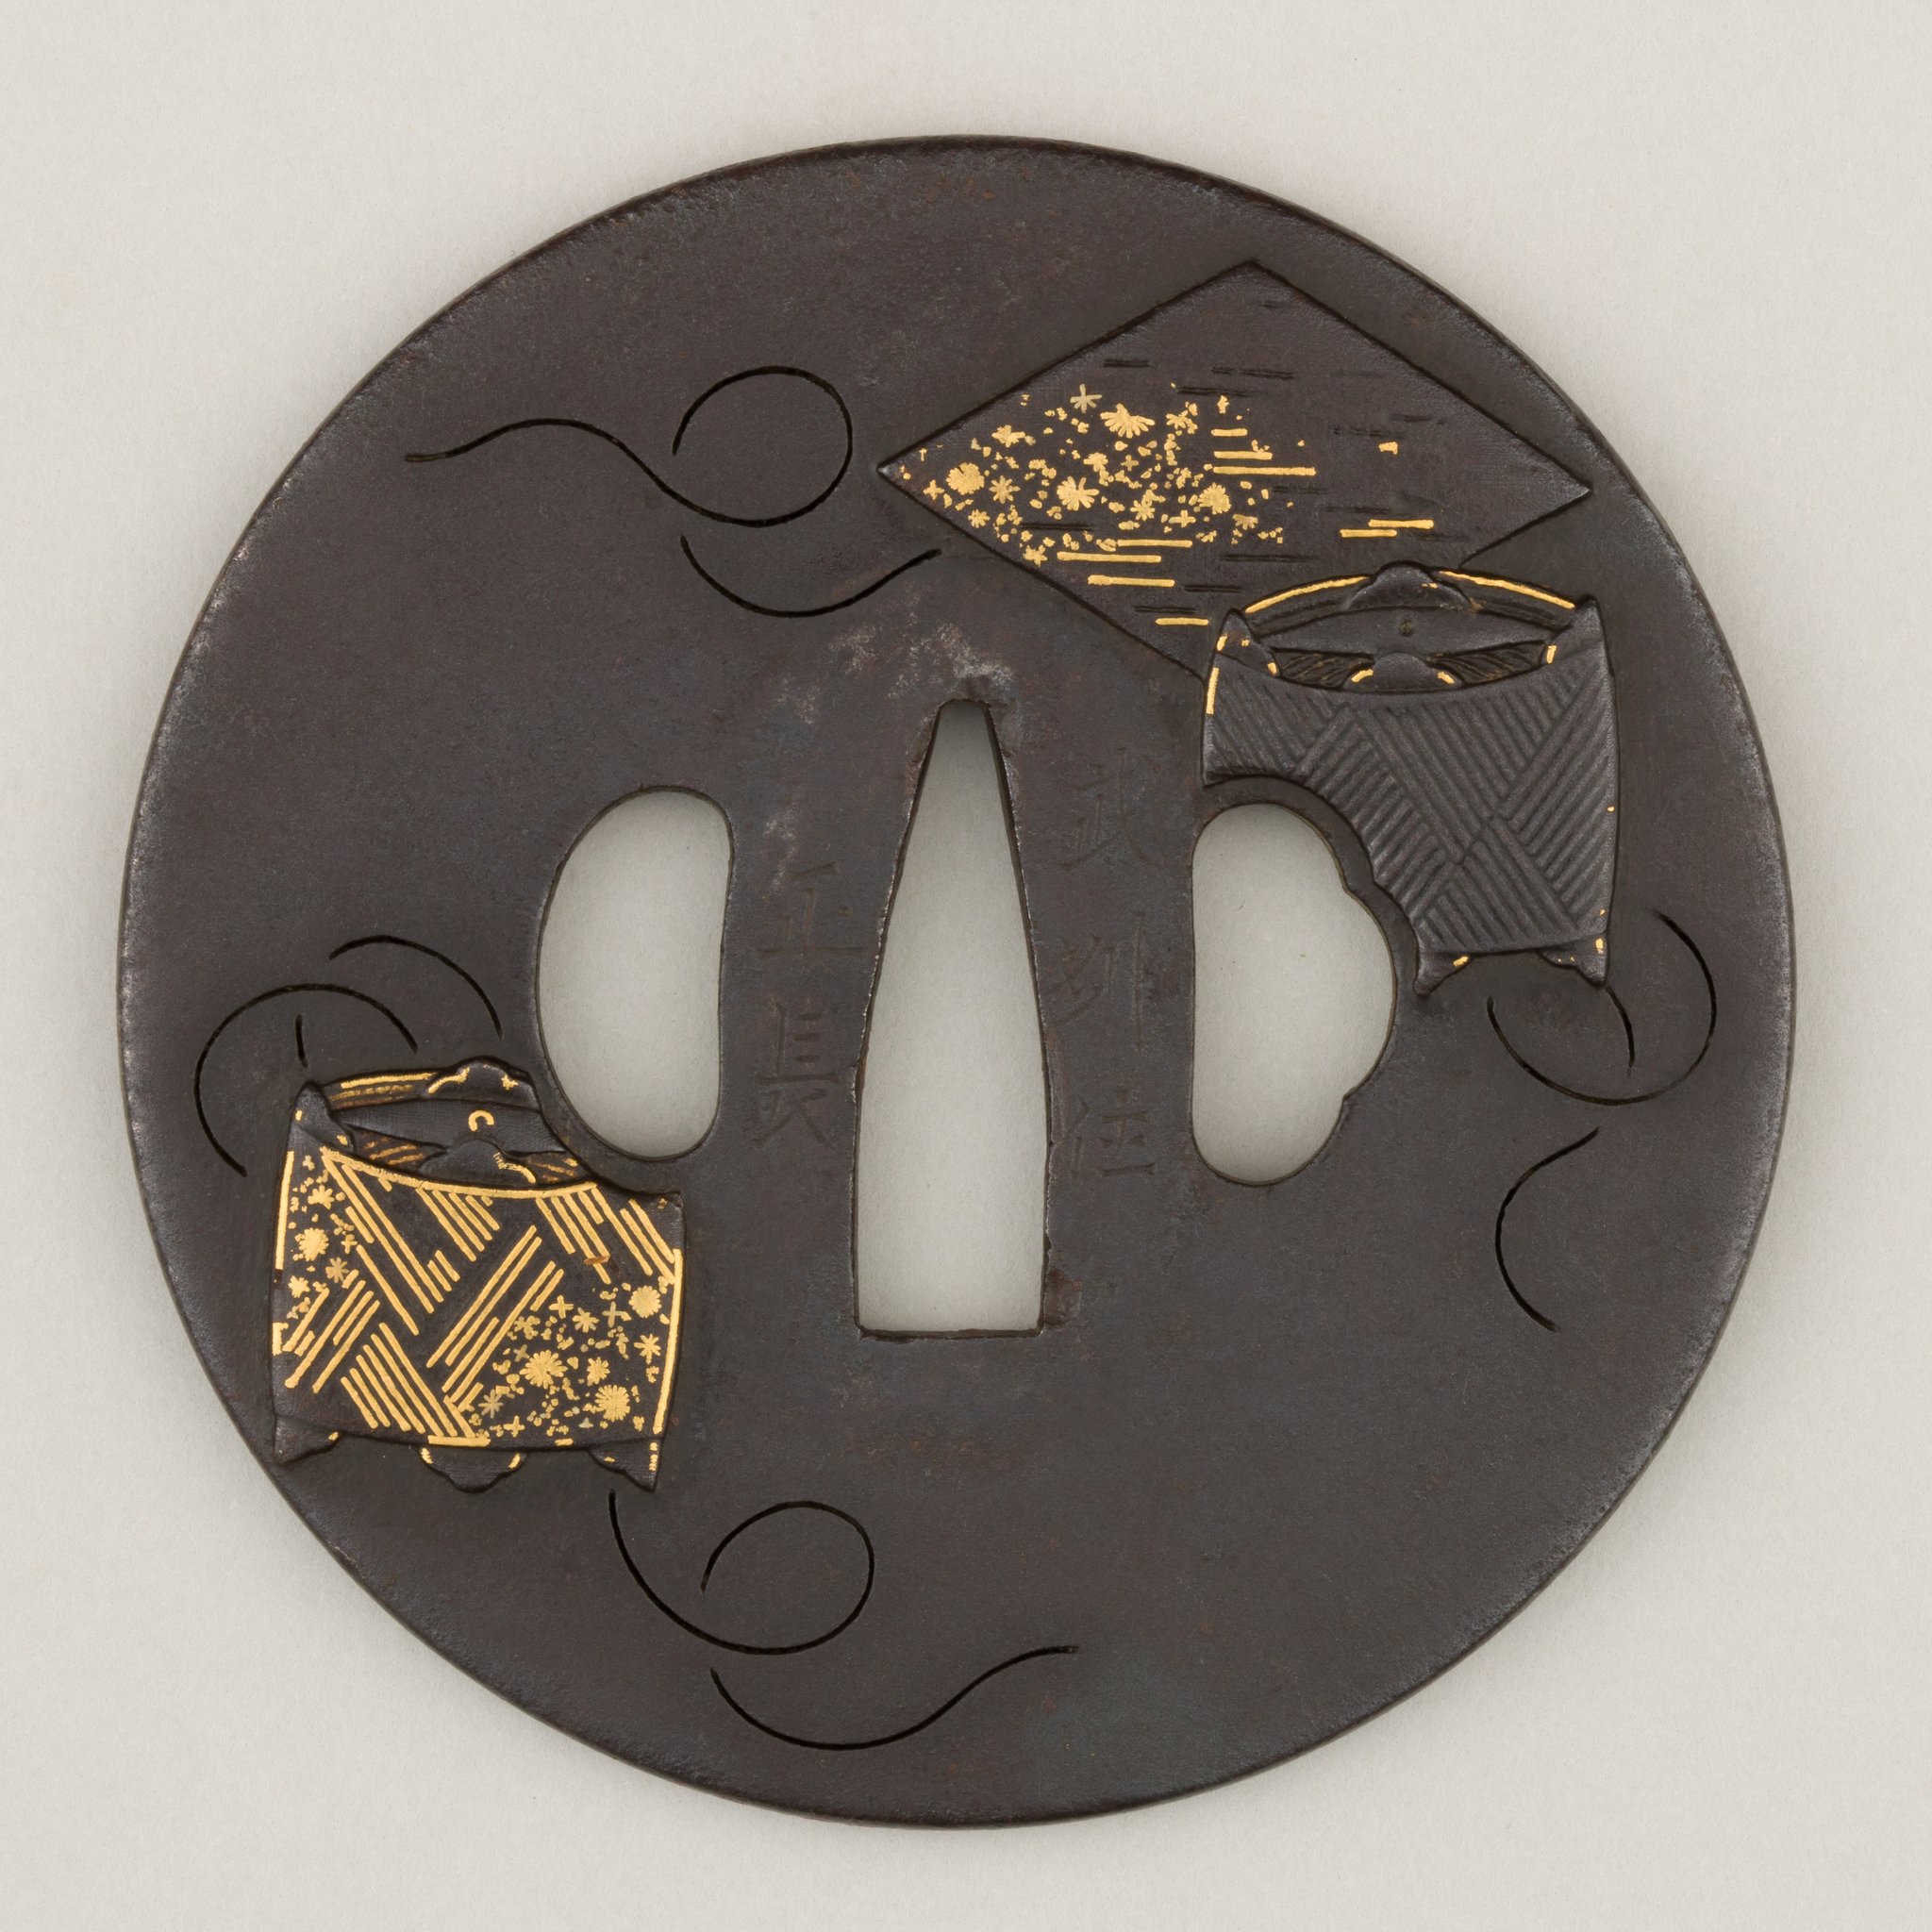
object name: sword guard tsuba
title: Sword Guard (Tsuba)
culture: japanese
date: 1701-1800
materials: copper, gold, iron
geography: japan